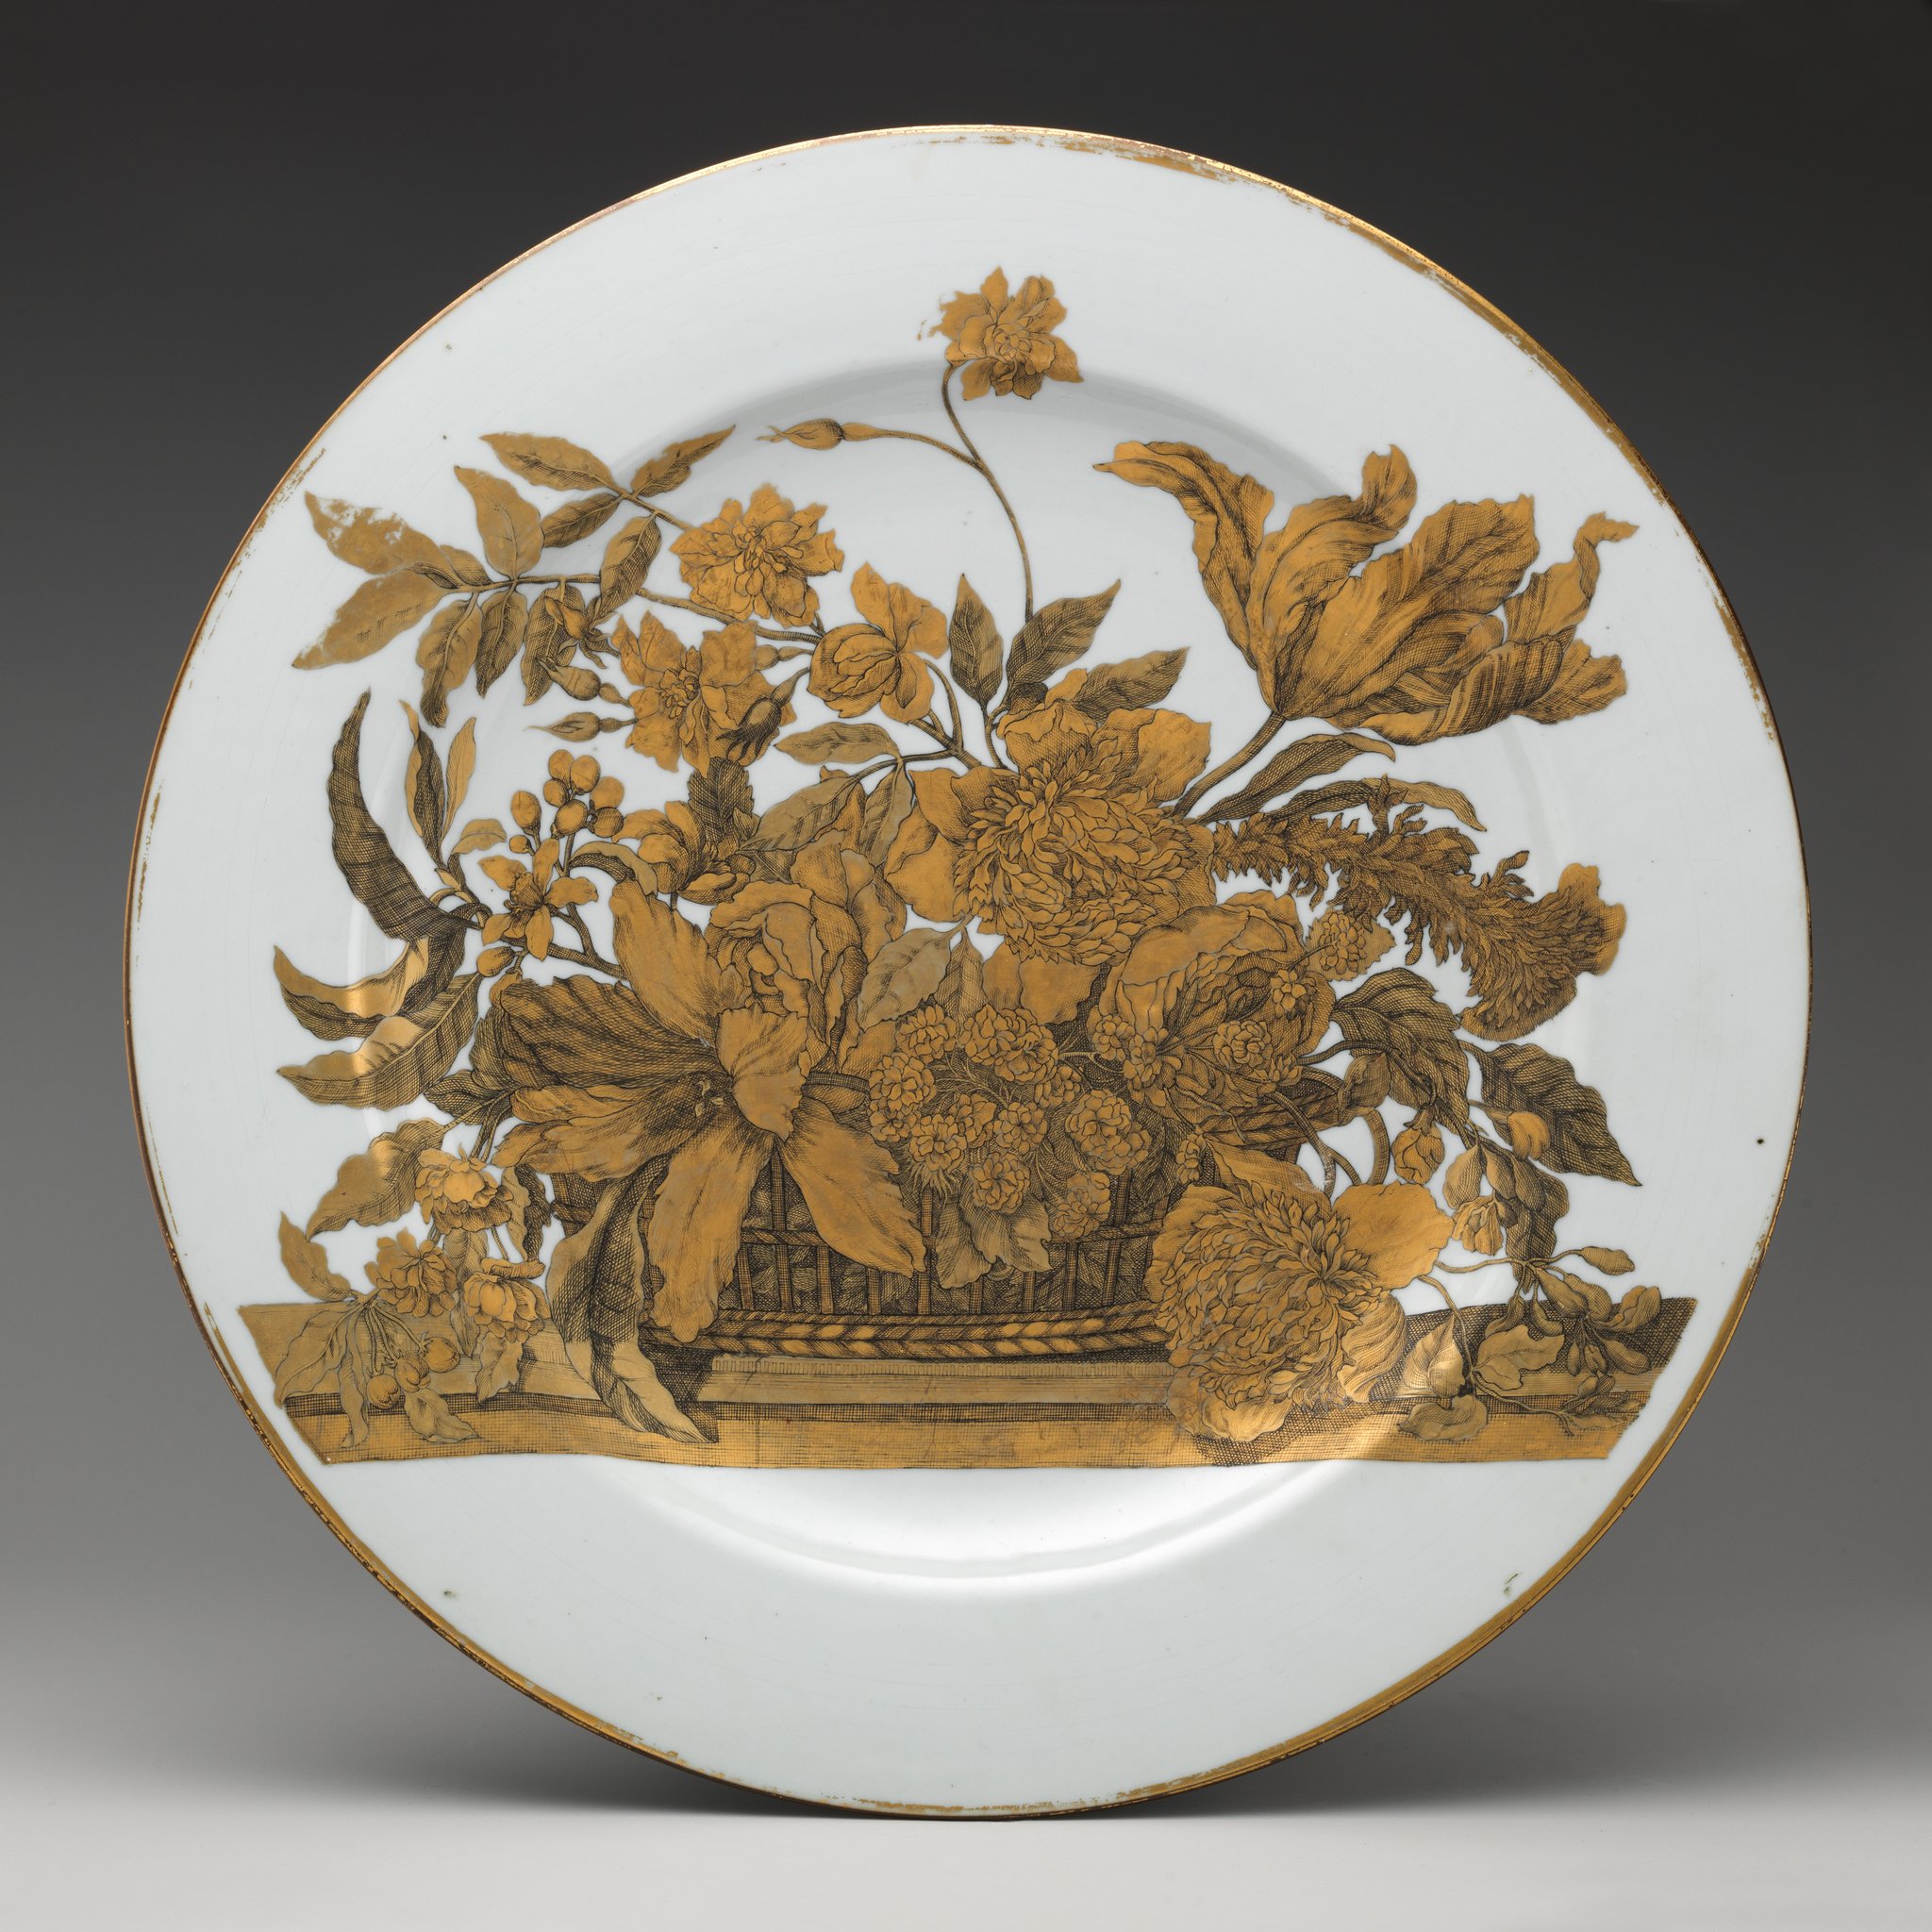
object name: plate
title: Plate (one of a pair)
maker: jean-baptiste monnoyer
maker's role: artist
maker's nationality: french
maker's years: 1636-1699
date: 1735-1740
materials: hard paste porcelain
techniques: gilding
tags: flowers